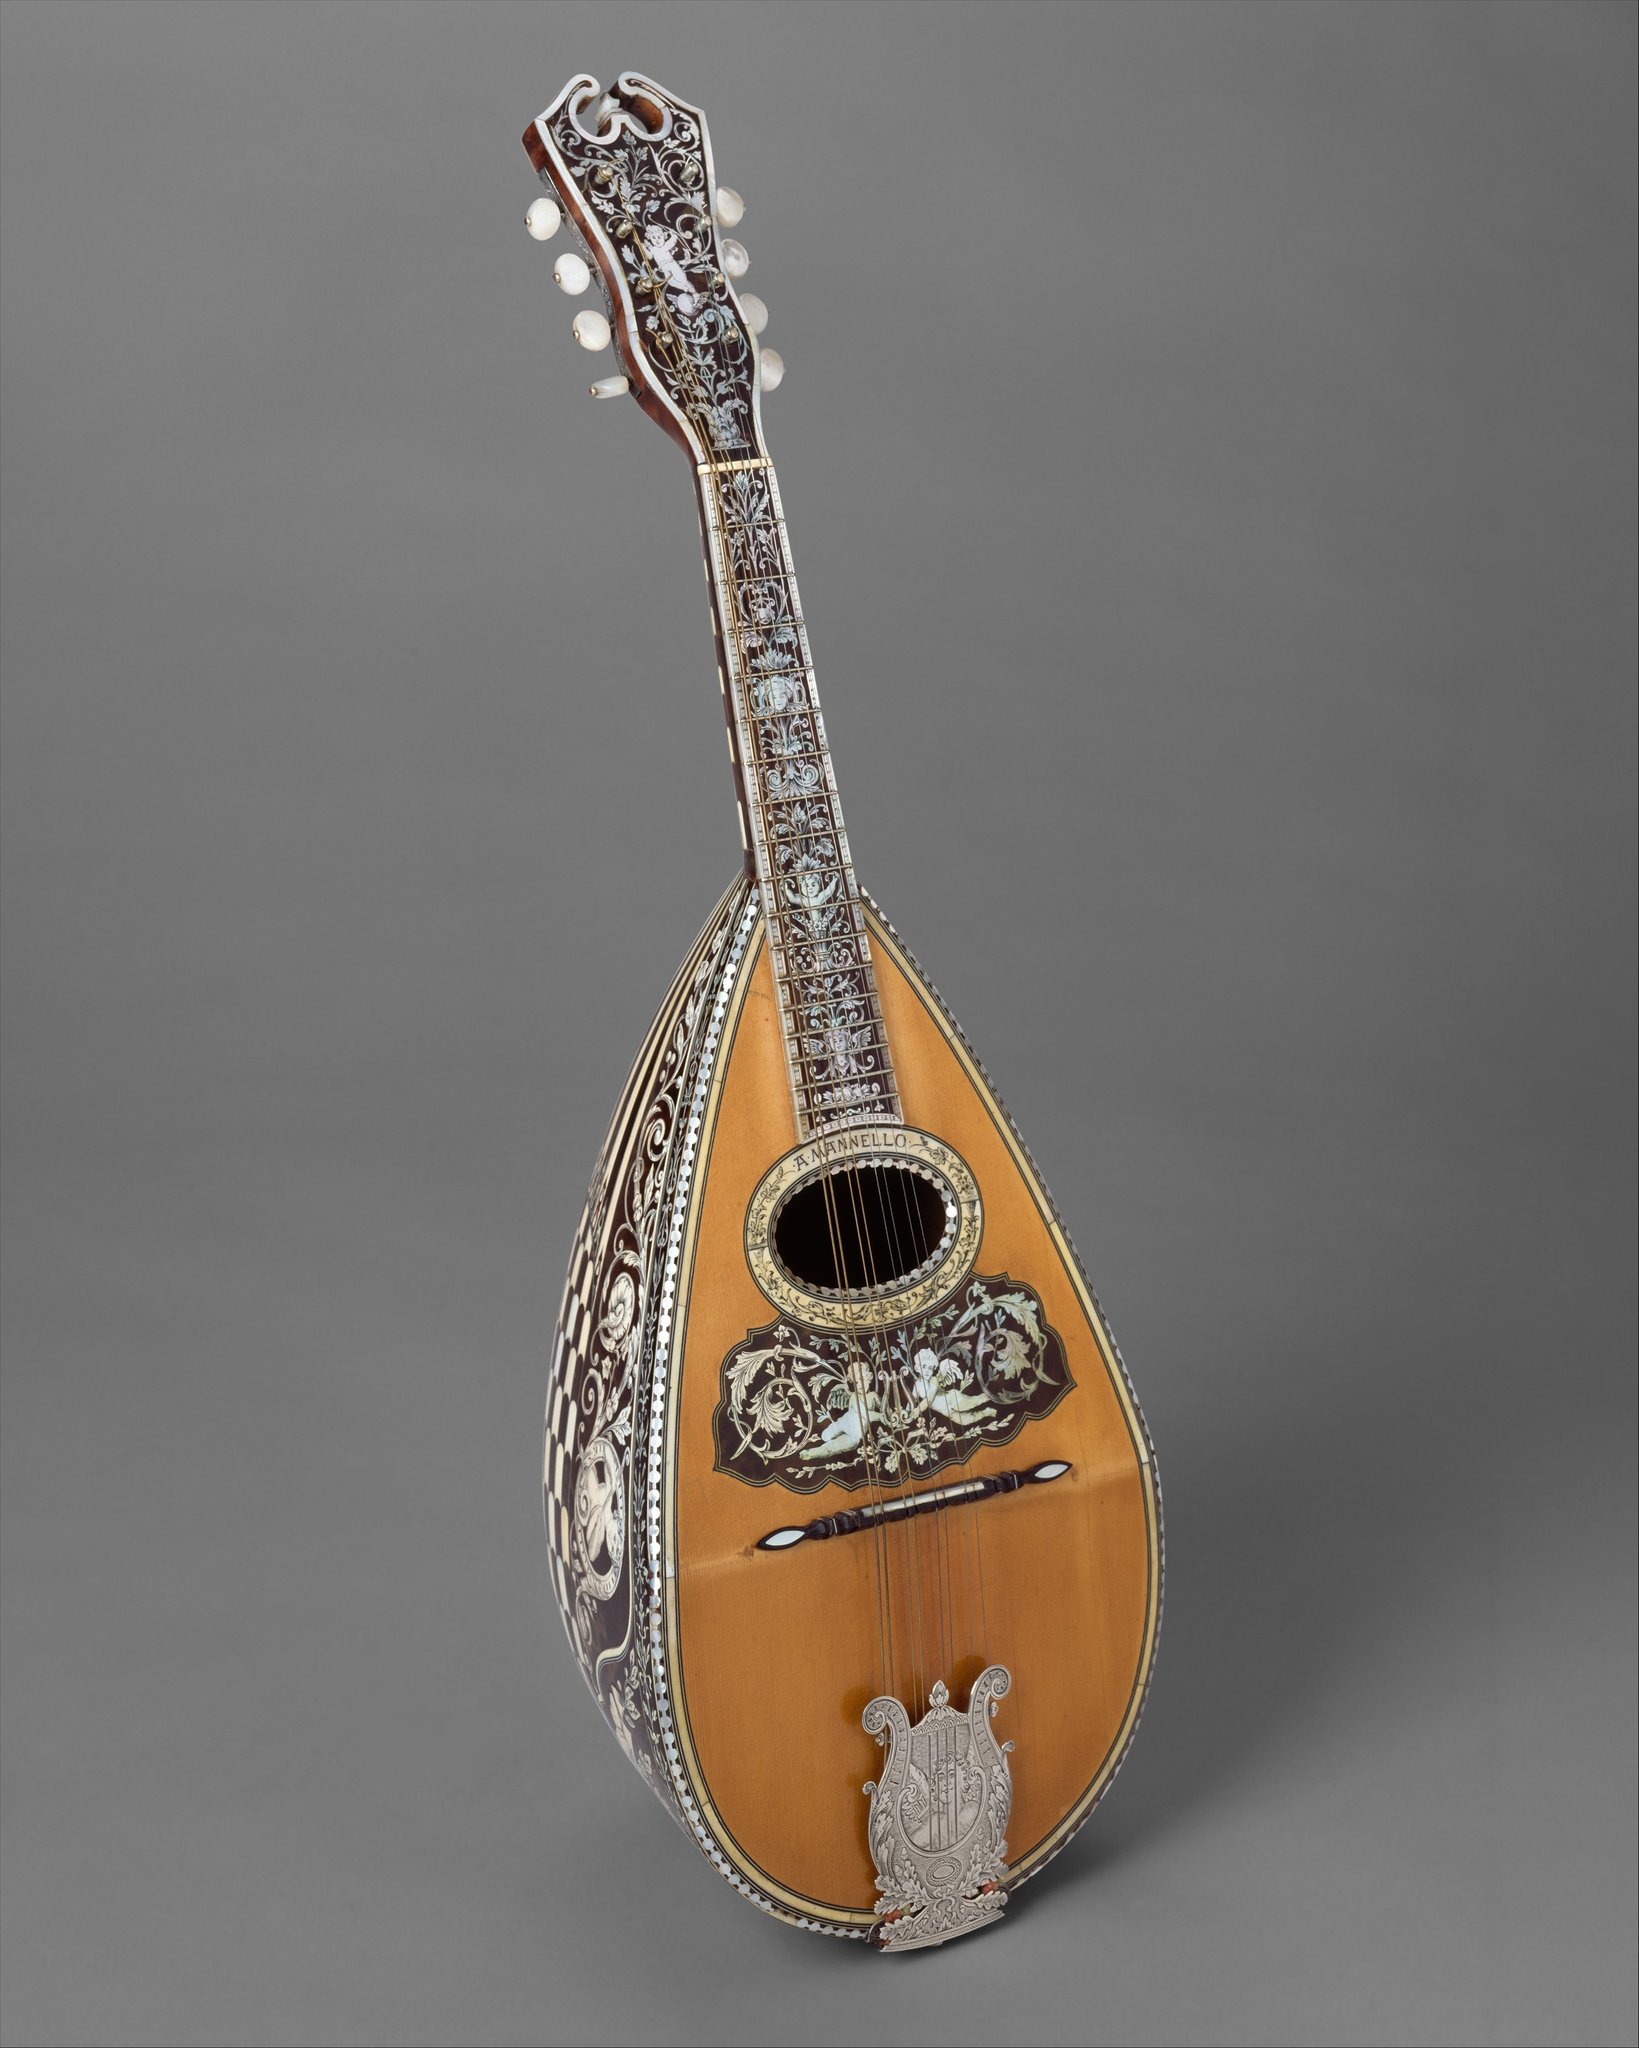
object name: mandolin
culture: american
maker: angelo mannello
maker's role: maker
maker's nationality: american, born italy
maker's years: 1858-1922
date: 1900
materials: ivory, metal, nickel, silver, wood, shell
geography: united states